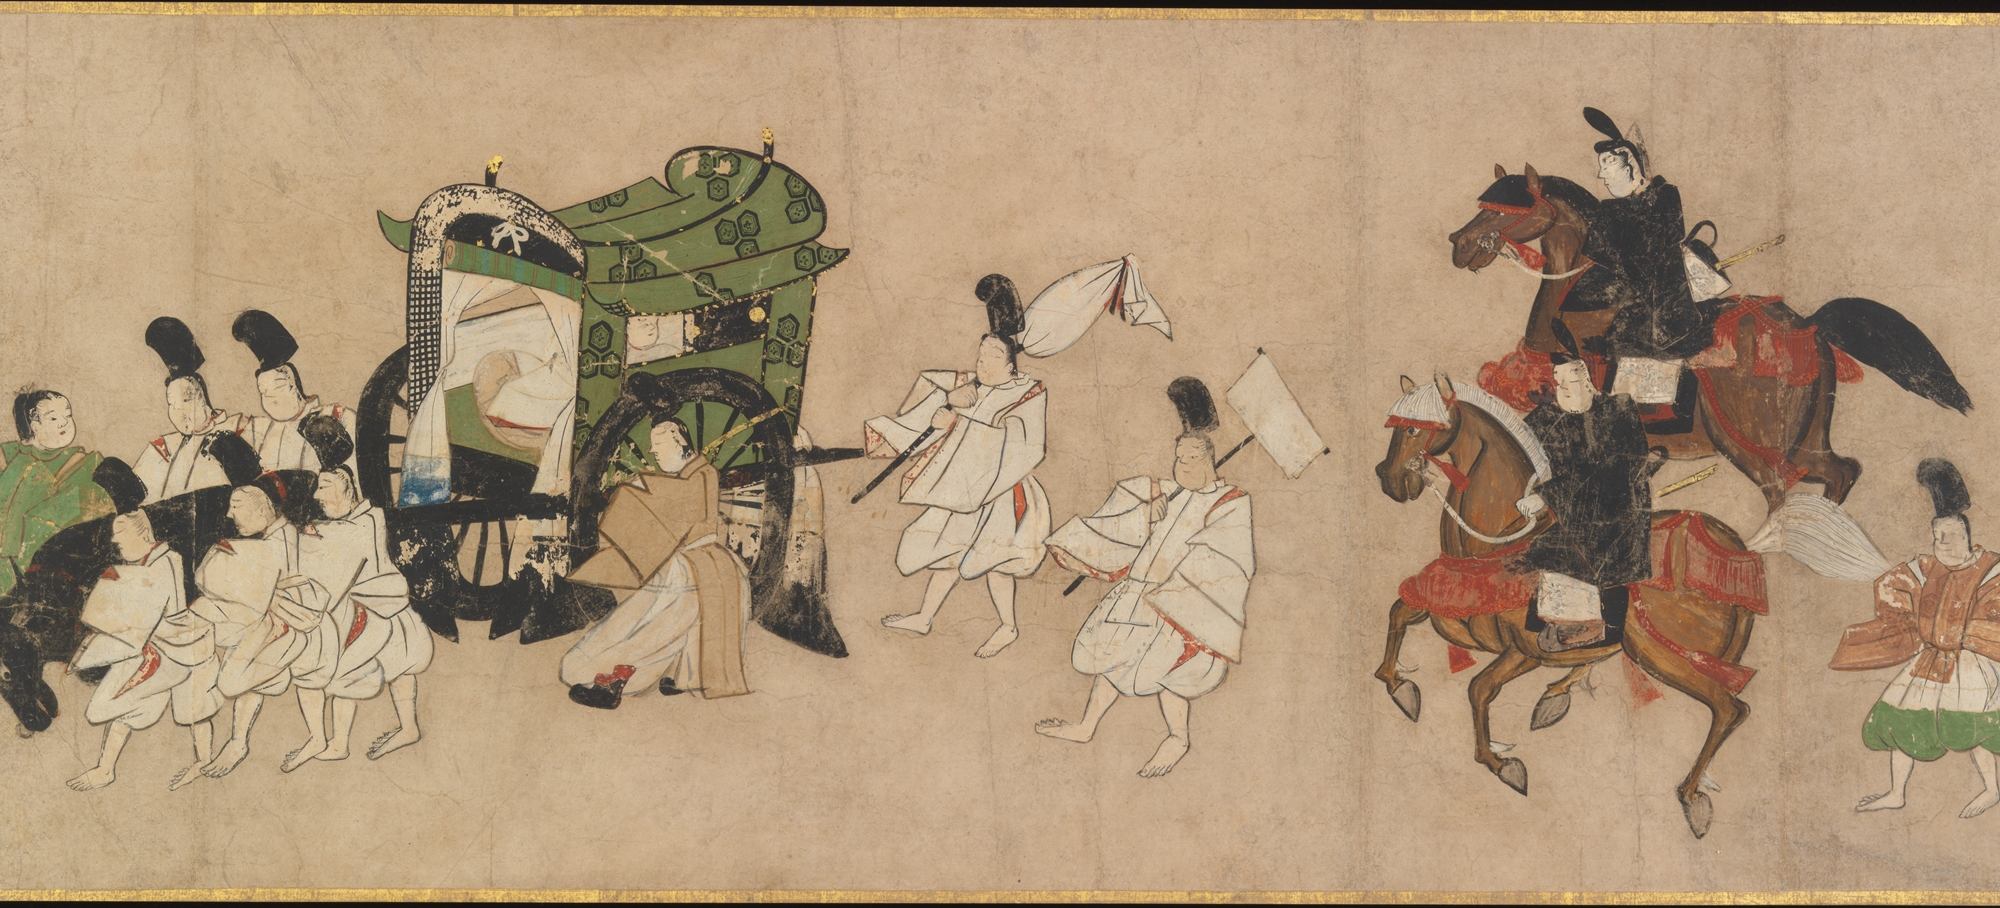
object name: handscroll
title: “Channel Markers” (Miotsukushi)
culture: japanese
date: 1367-1433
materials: ink, paper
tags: men,horses,carriages